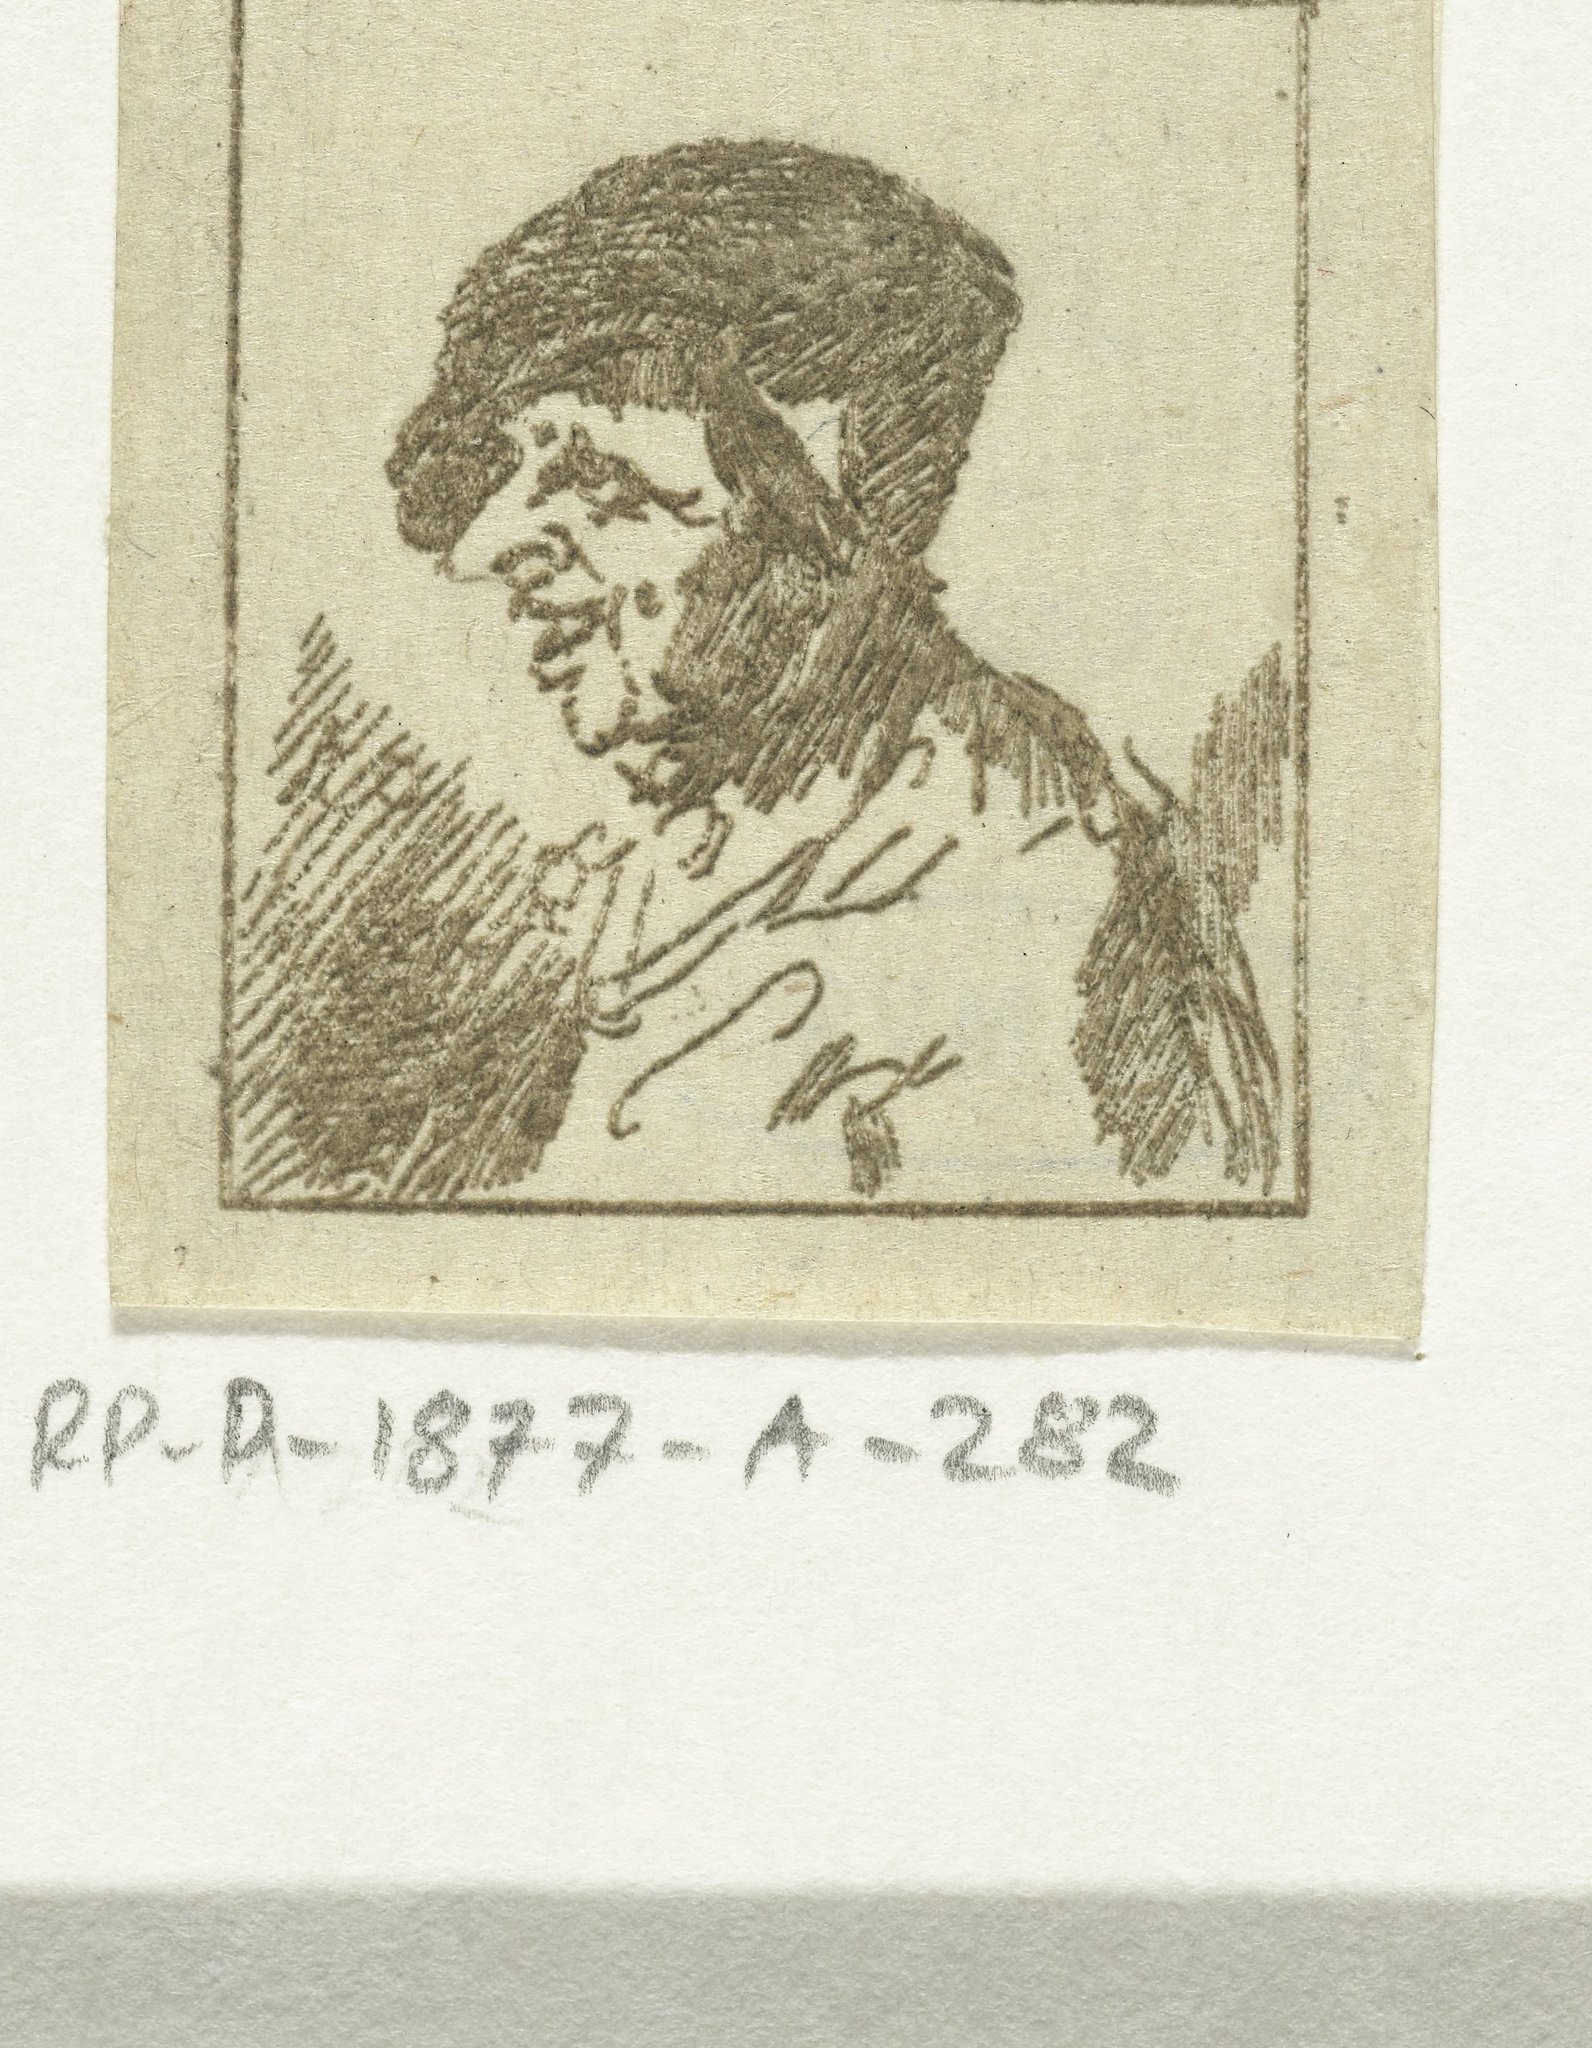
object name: print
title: Buste van een lachende boer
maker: anthonie van den bos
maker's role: draughtsman, print maker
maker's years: 1763-1838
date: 1778-1838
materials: paper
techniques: etching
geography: netherlands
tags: head-gear: cap (+ men's clothes), laughing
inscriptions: collector's mark: Lugt 2228